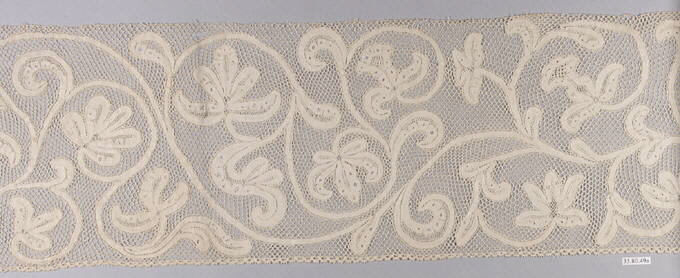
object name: border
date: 1701-1800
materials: lace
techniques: lace